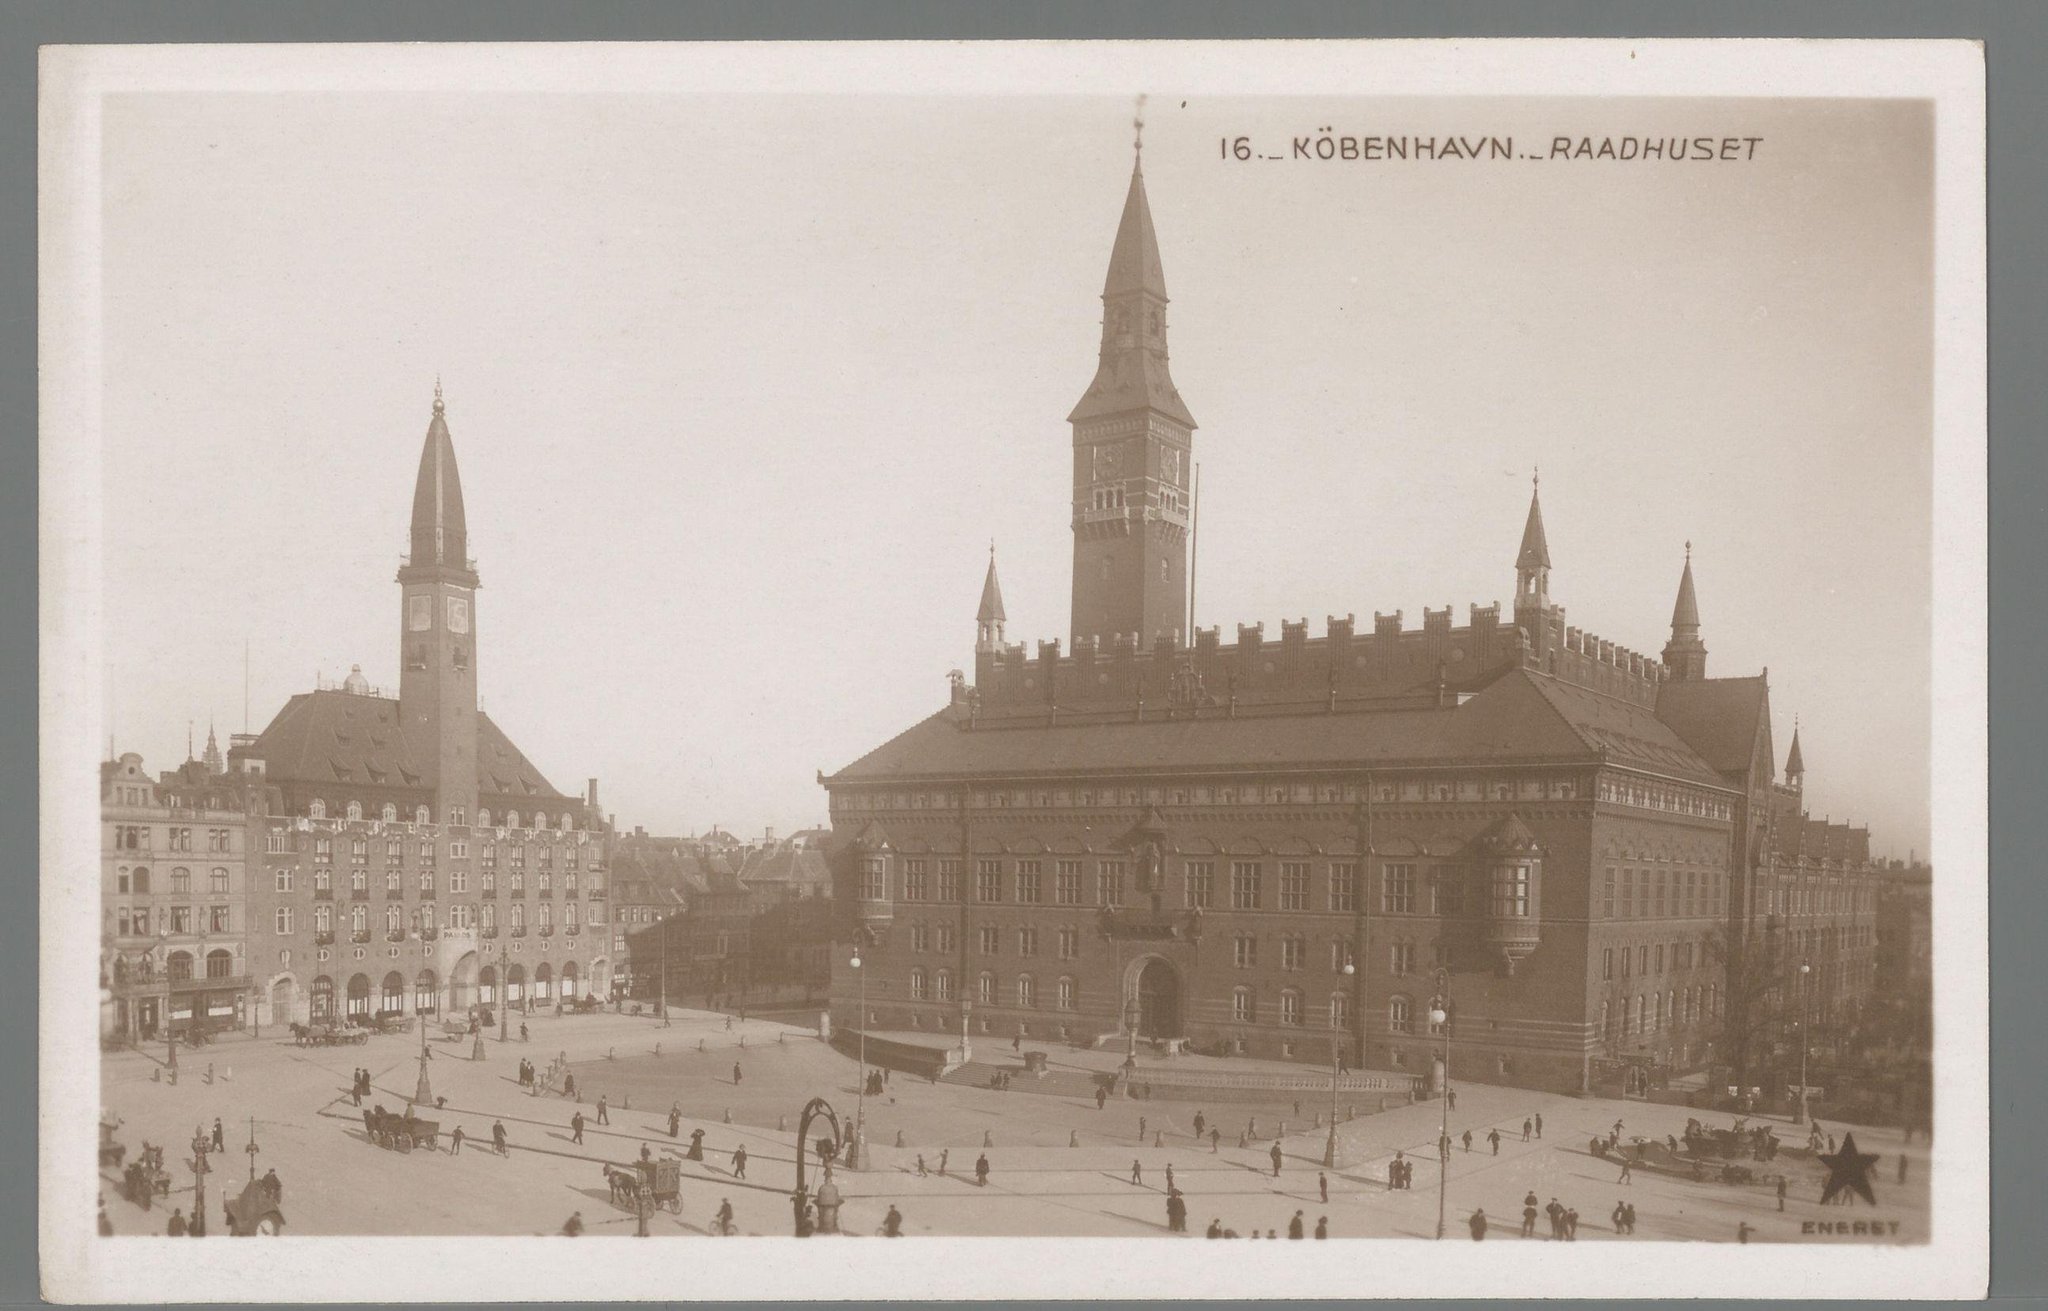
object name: photograph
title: Köbenhavn. Raadhuset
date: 1906-1920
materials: photographic support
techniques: photography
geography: copenhagen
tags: townhall, square, place, circus, etc. (+ city(-scape) with figures, staffage), copenhagen (city)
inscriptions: mark